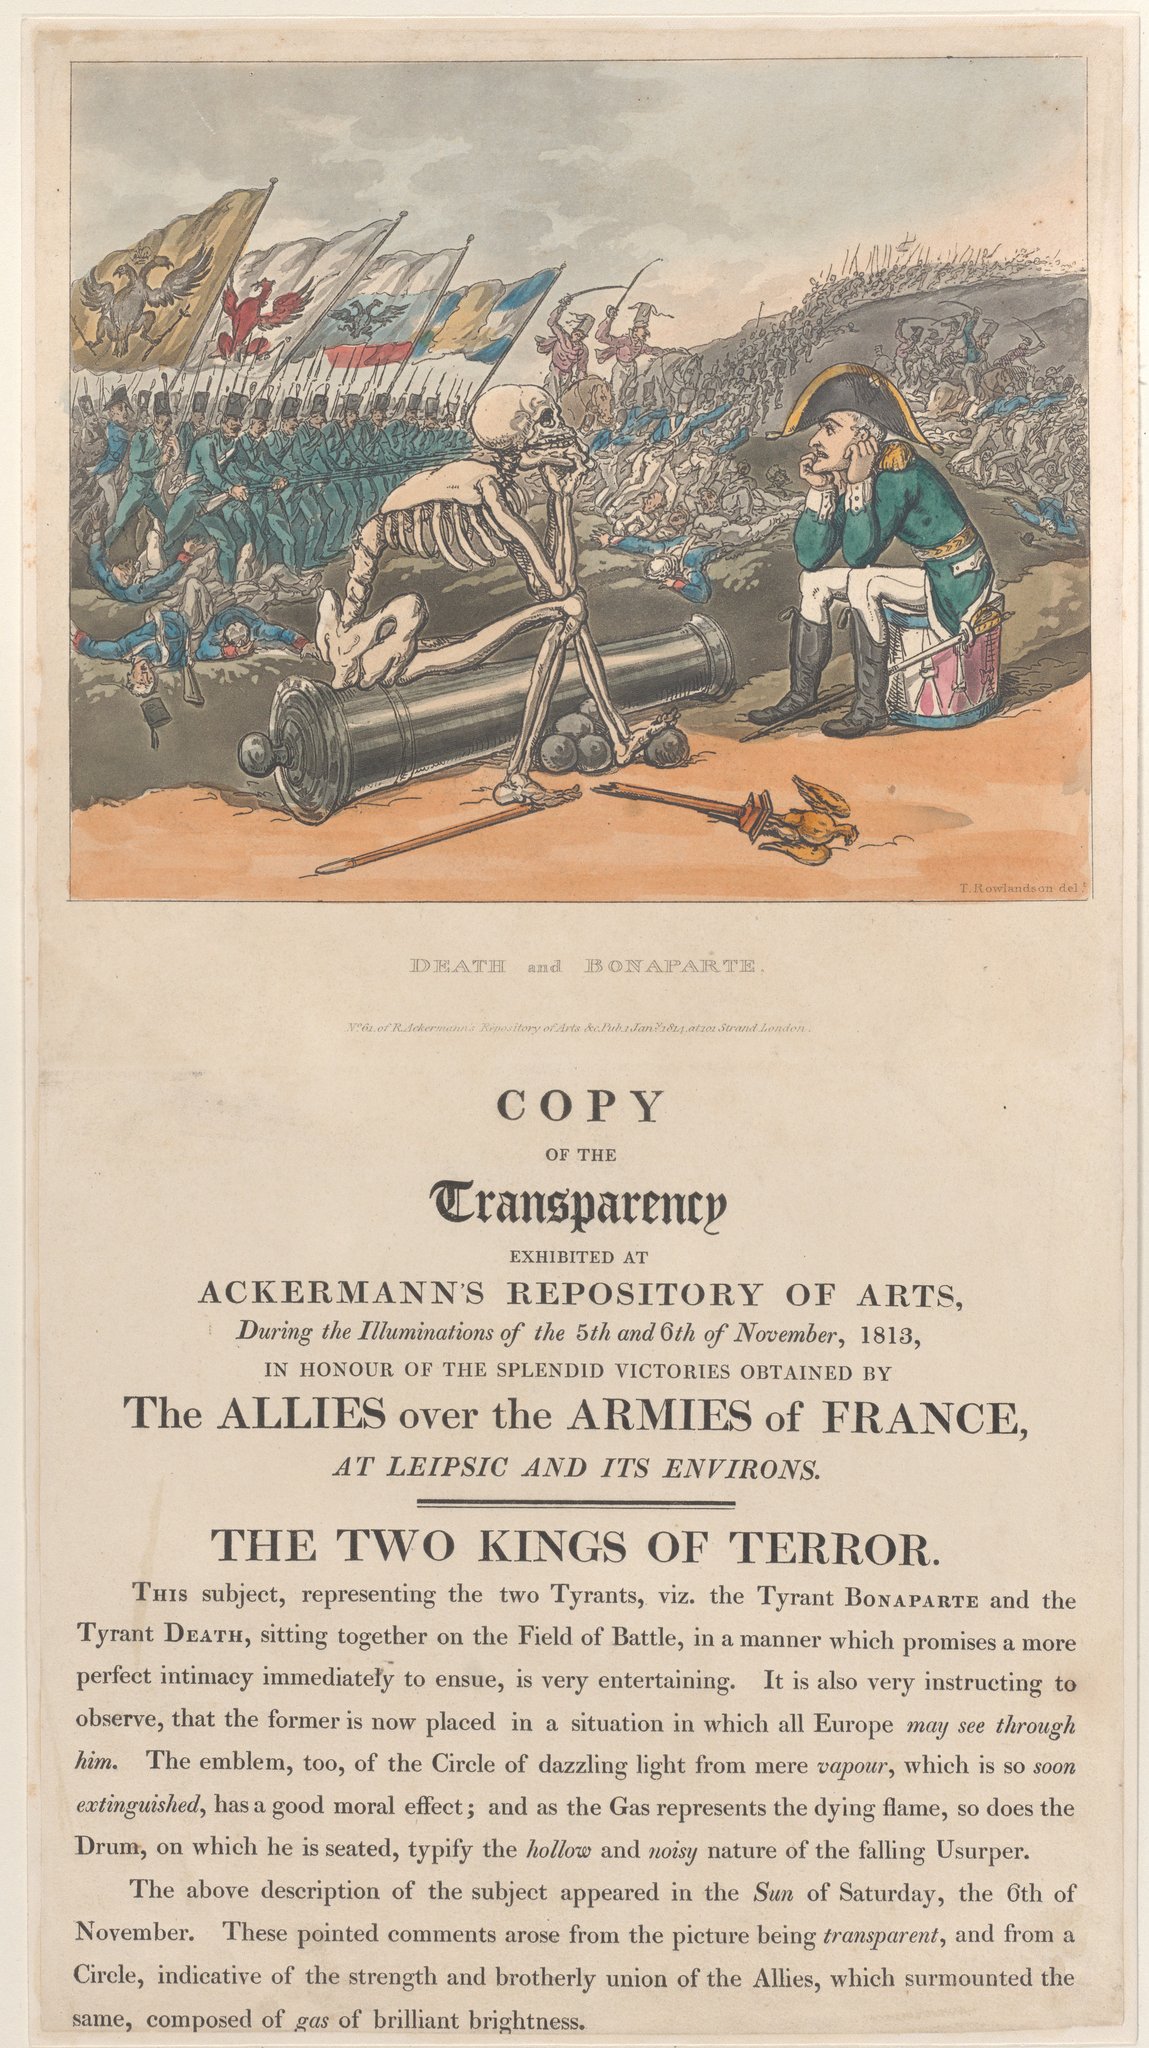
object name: print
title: Death and Bonaparte, The Two Kings of Terror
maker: thomas rowlandson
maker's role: artist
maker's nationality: british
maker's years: 1757-1827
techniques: etching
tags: satire,soldiers,cannons,napoleon i,skeletons,politics